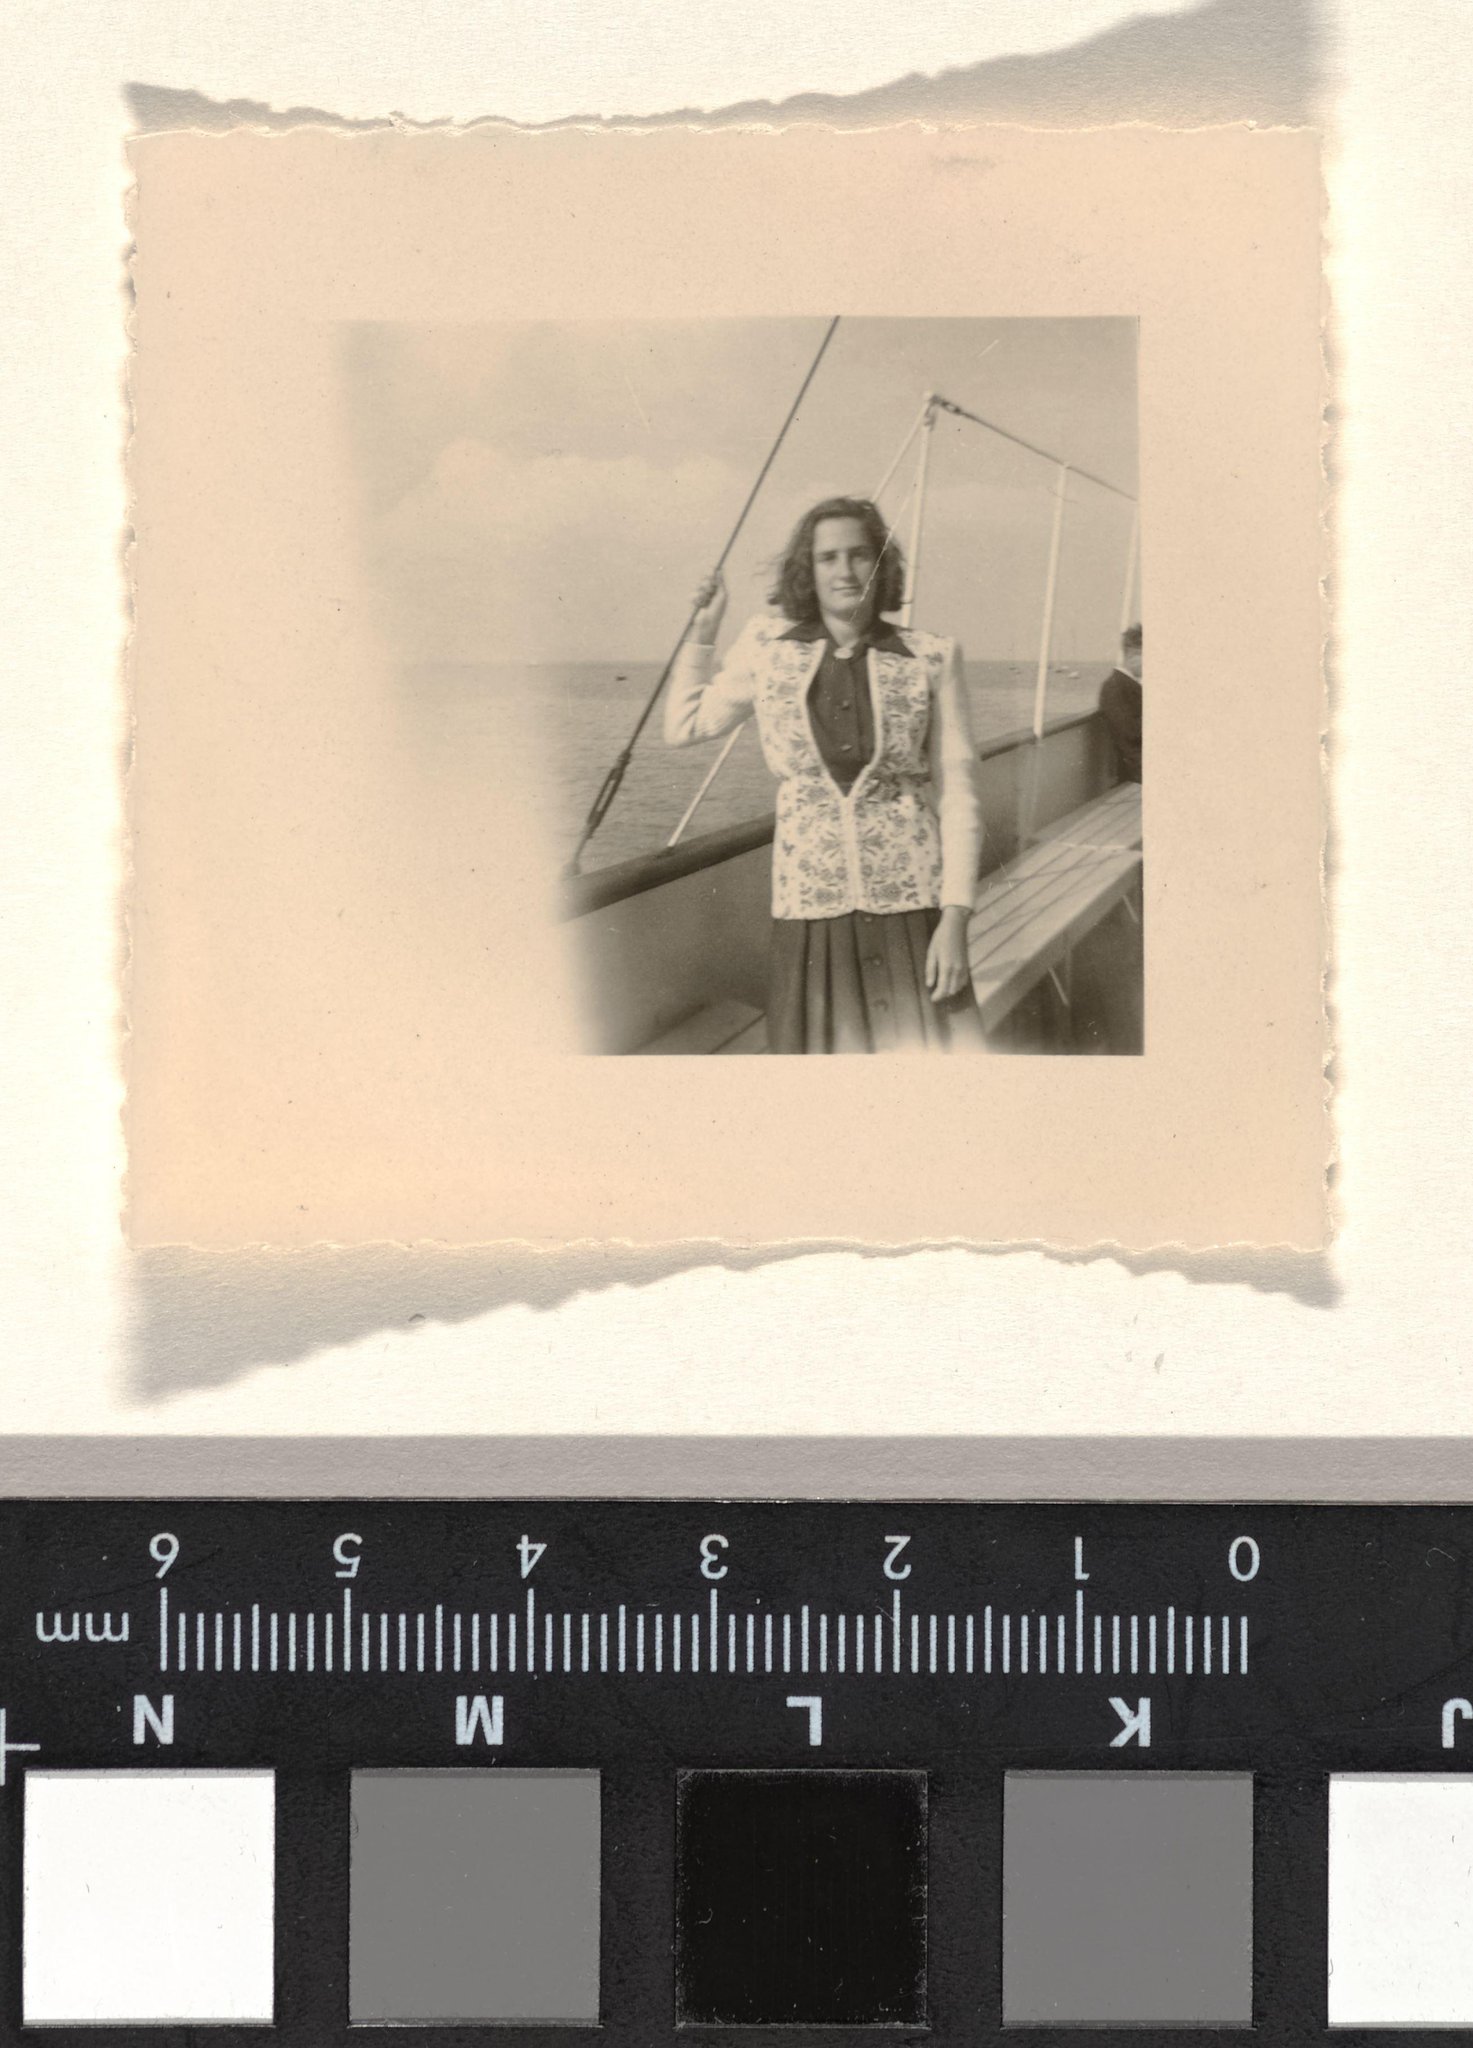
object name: photograph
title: Isabel Wachenheimer staand op een boot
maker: Anonymous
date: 1945-1956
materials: photographic support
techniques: gelatin silver print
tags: leiden, isabel wachenheimer-elon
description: Isabel Wachenheimer in licht vest met bloemenmotief, staand op een boot met haar hand aan een verbindingskabel.